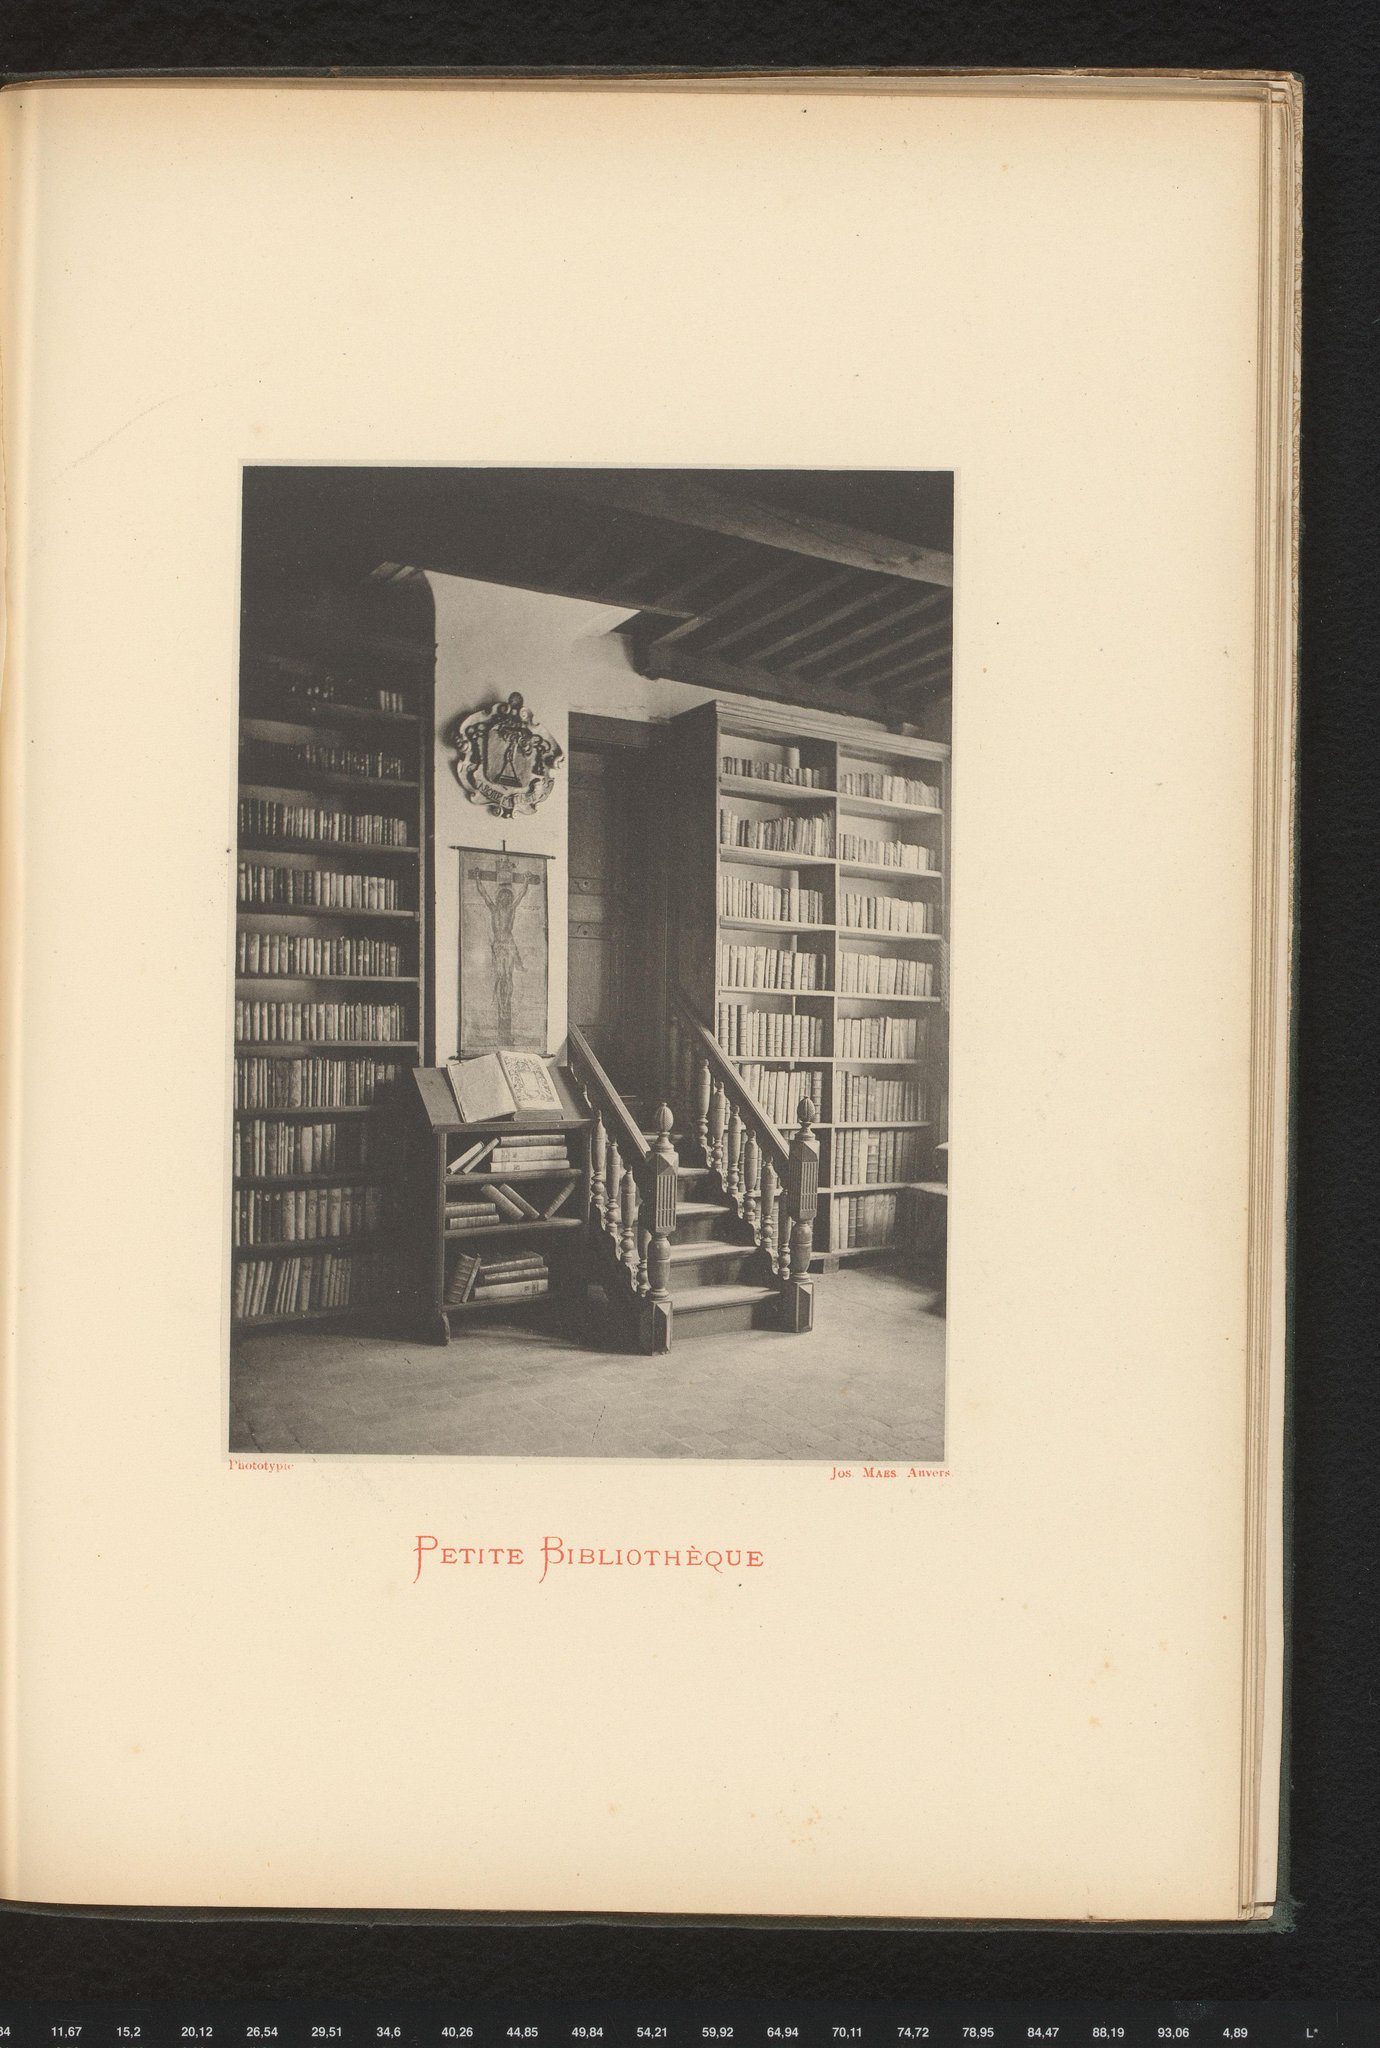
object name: page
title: Petite bibliothèque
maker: joseph maes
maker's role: fotograaf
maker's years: 1838-1908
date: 1877-1882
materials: paper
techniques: photograph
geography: antwerp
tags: study; 'studiolo'; library